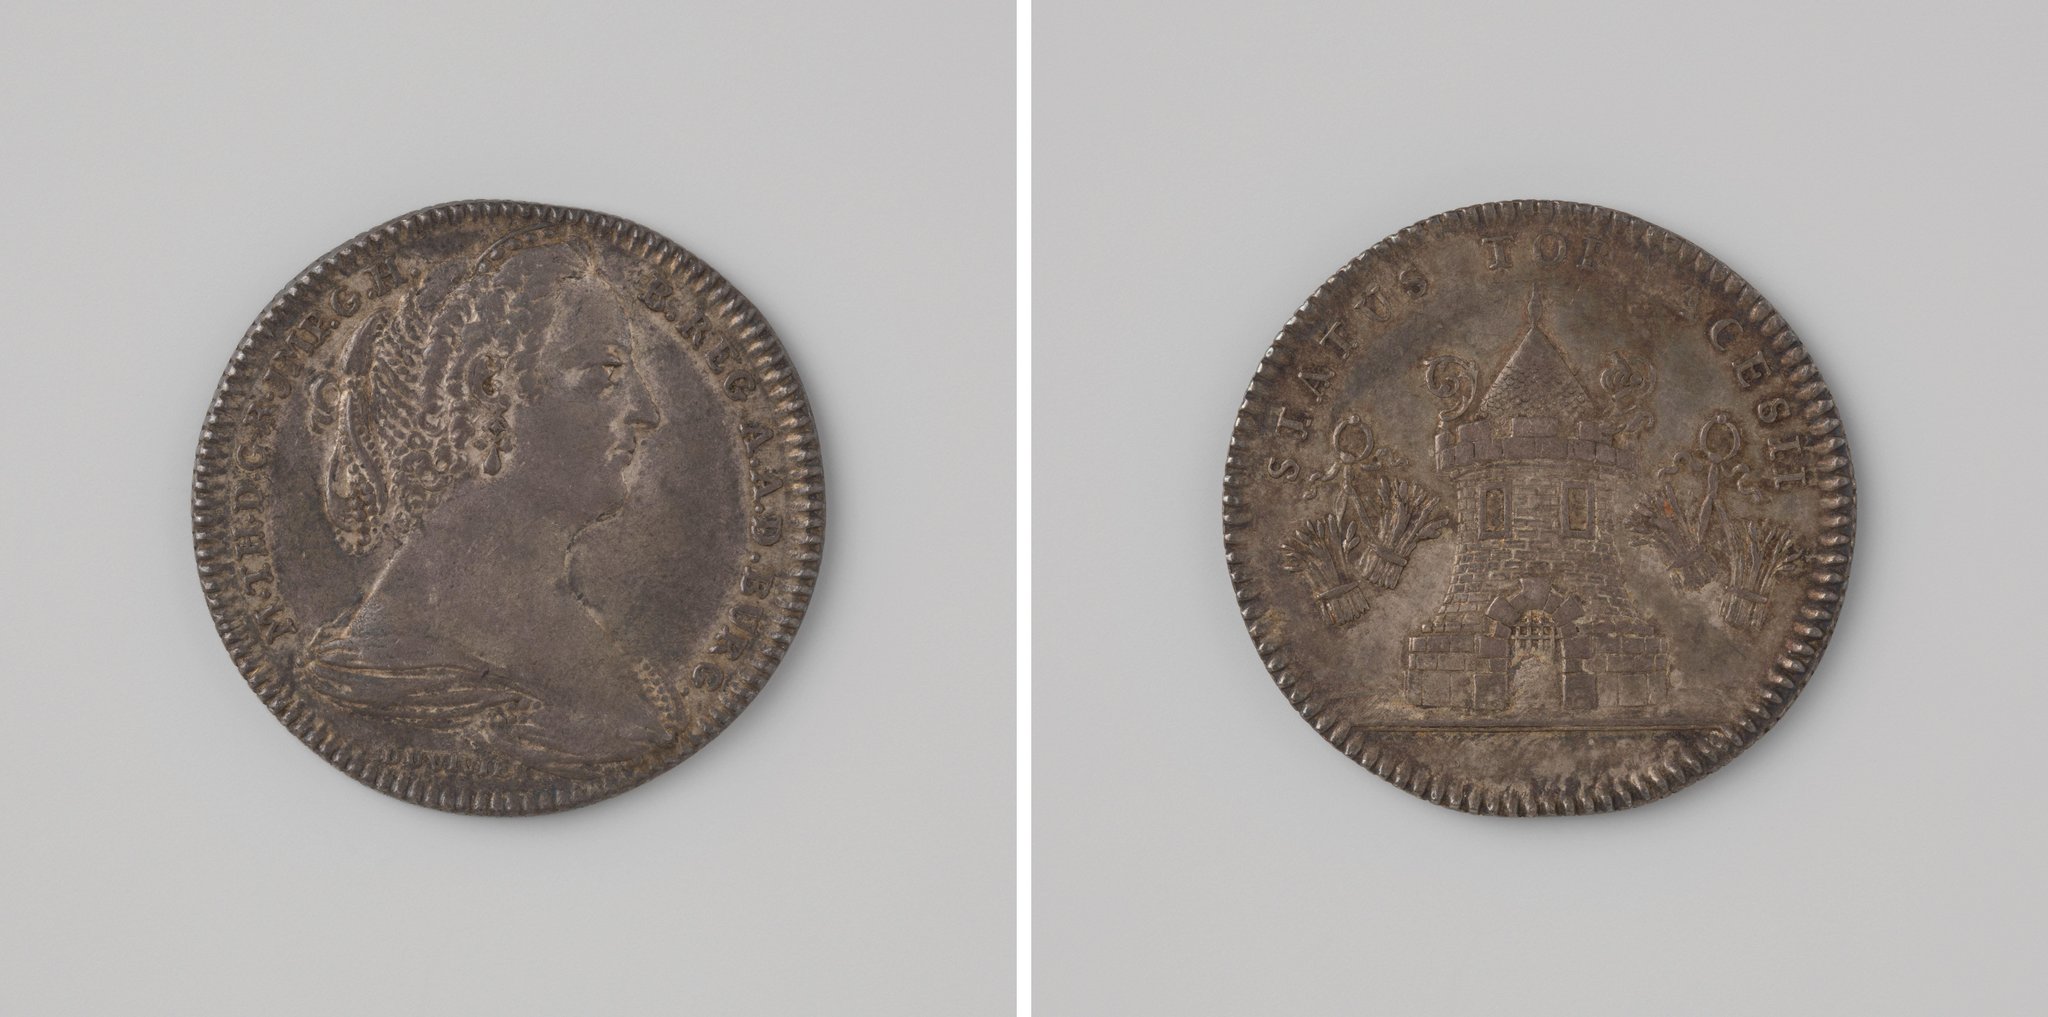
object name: jeton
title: Maria Theresia, Duits keizerin, penning geslagen door stad Doornik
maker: claude duvivier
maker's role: silversmith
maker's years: 1688-1747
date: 1740-1780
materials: silver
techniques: striking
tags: vienna, maria theresia (rooms-duits keizerin)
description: Zilveren penning. Voorzijde: borststuk vrouw binnen omschrift. Keerzijde: toren, met daarop helm met aan weerszijden ring, waaraan met lint twee korenschoven zijn verbonden binnen omschrift